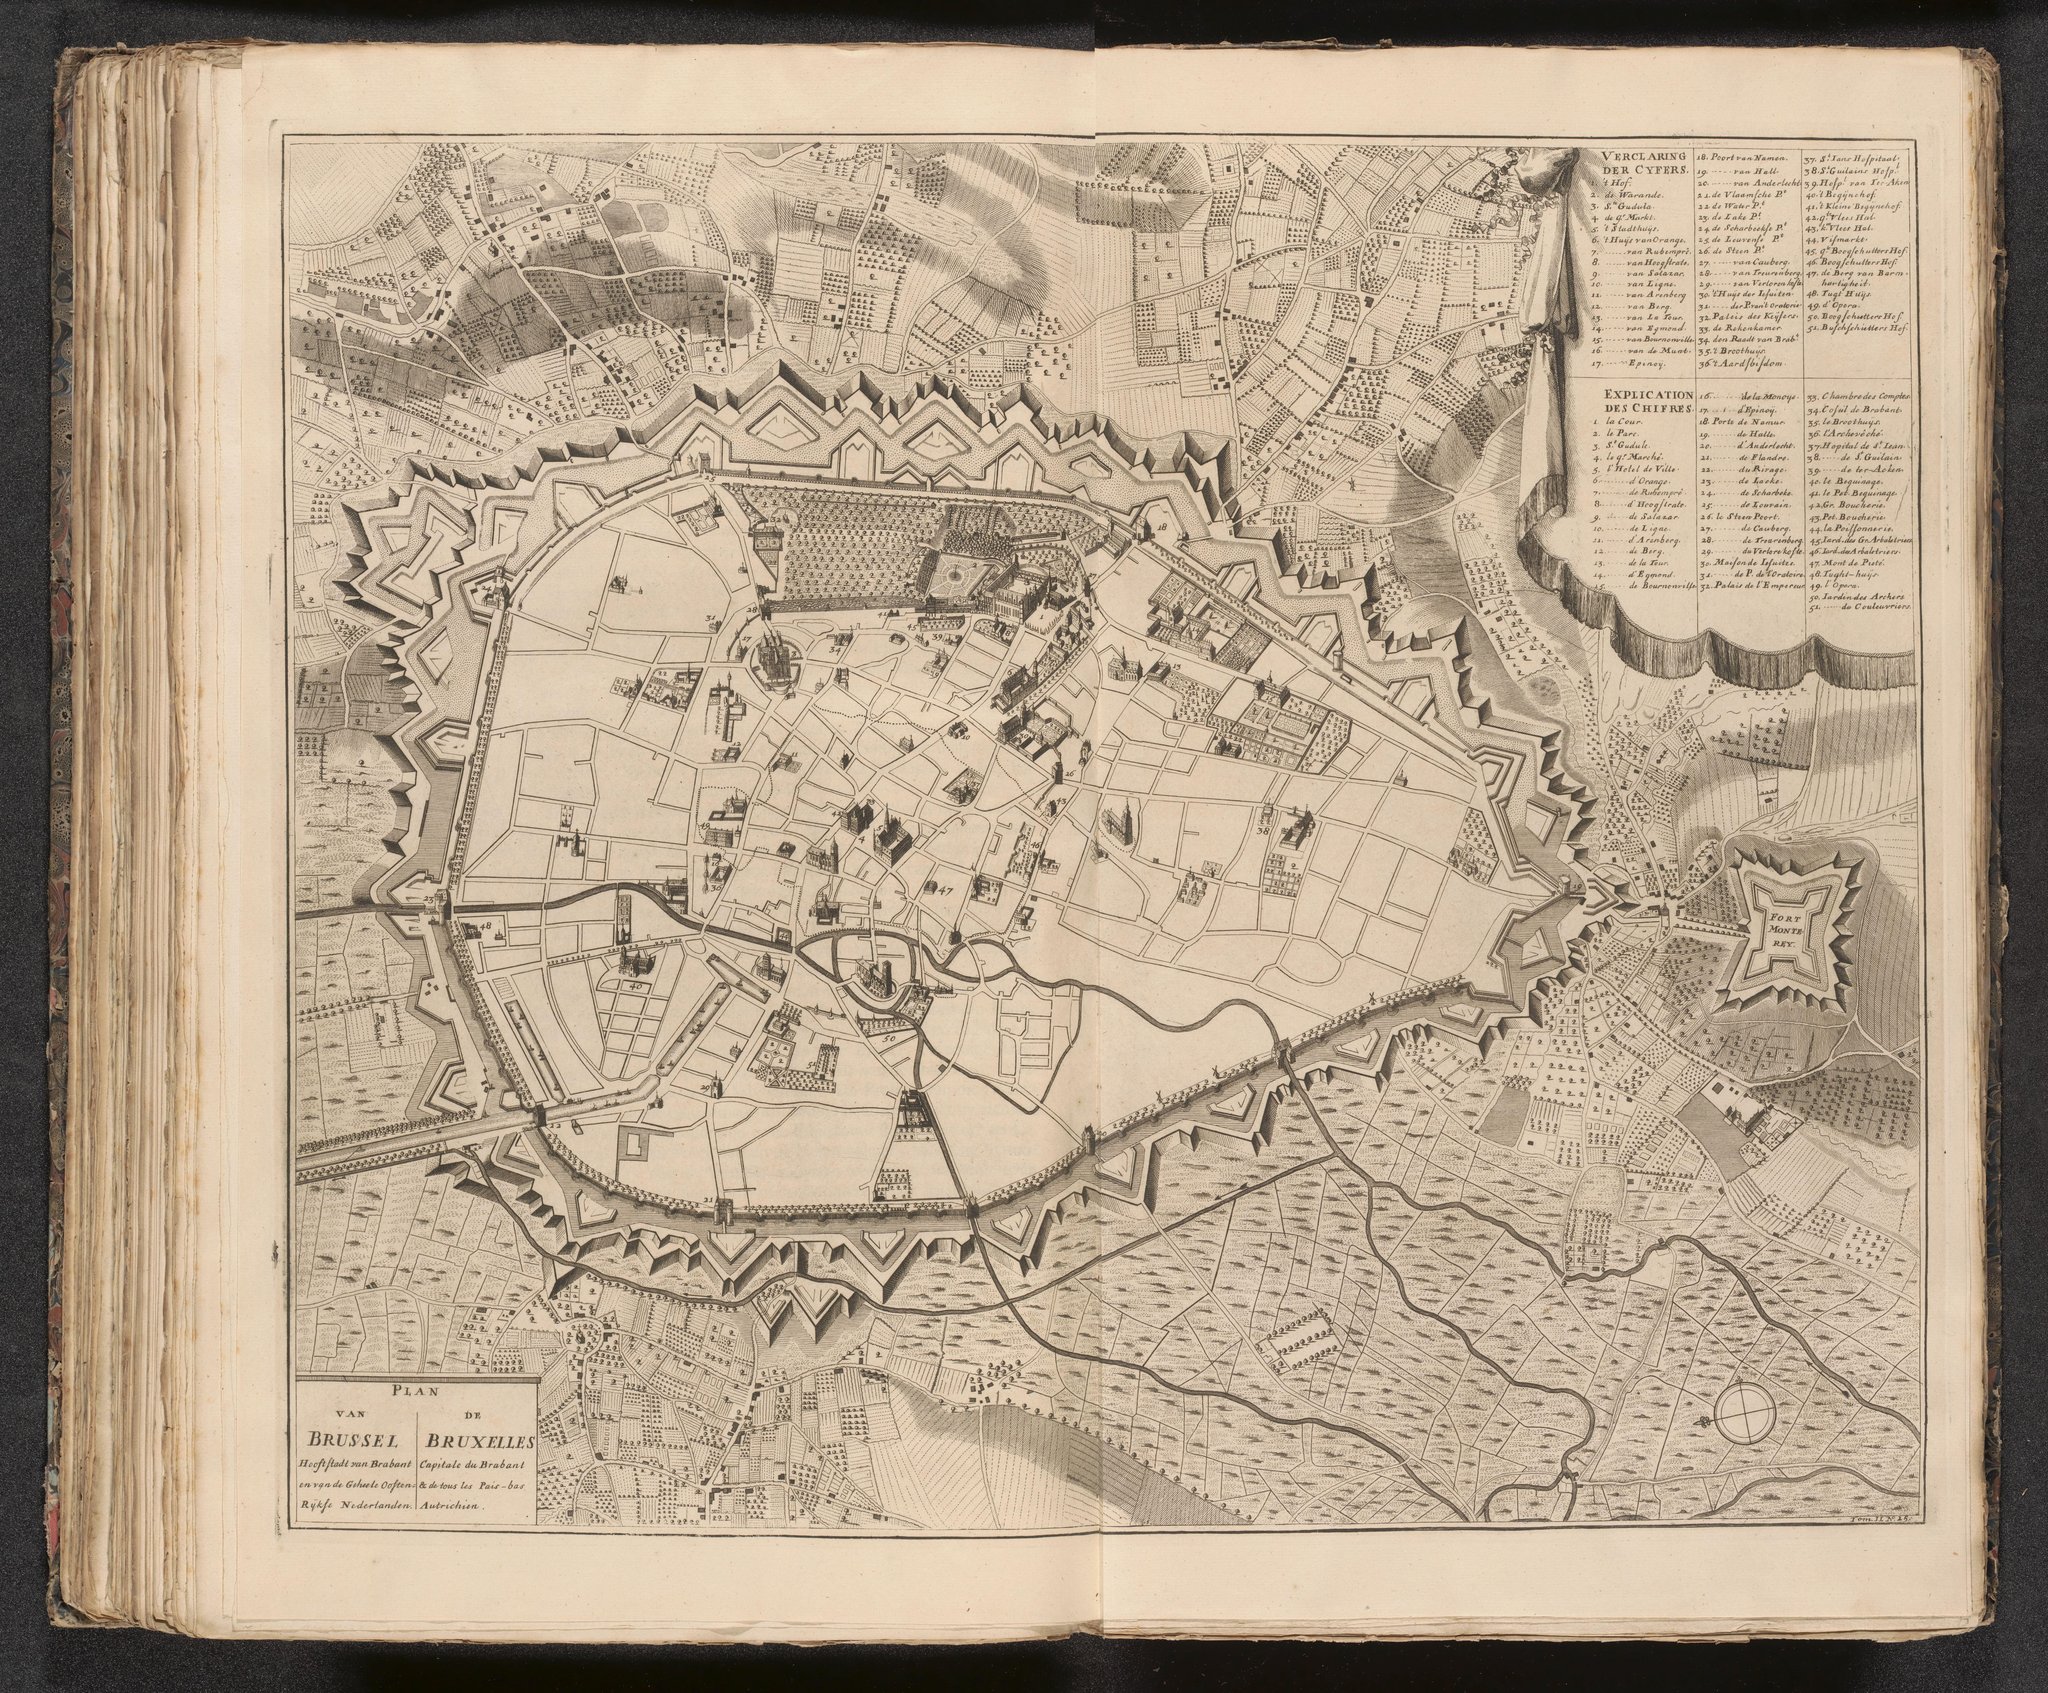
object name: map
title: Plattegrond van Brussel, ca. 1701-1713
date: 1727-1729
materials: paper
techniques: etching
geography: northern netherlands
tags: johan willem friso (prins van oranje-nassau), john churchill (1e hertog van marlborough), maps of cities, brussels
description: Plattegrond van Brussel, ca. 1701-1713. Genummerd rechtsonder: Tom. II. No. 25. Illustratie in het tweede deel van : [Jean] du Mont, Oorlogskundige beschryving van de veldslagen en belegeringen, der drie ... wydvermaarde krygsoversten... den Prins Eugenius van Savoye, den ... Hertog van Marlborough, en den Prins van Oranje en Nassau-Vriesland, in de editie van 1729. Dit tweede deel is hoofdzakelijk gewijd aan de daden van de hertog van Marlborough en prins Johan Willem Friso.